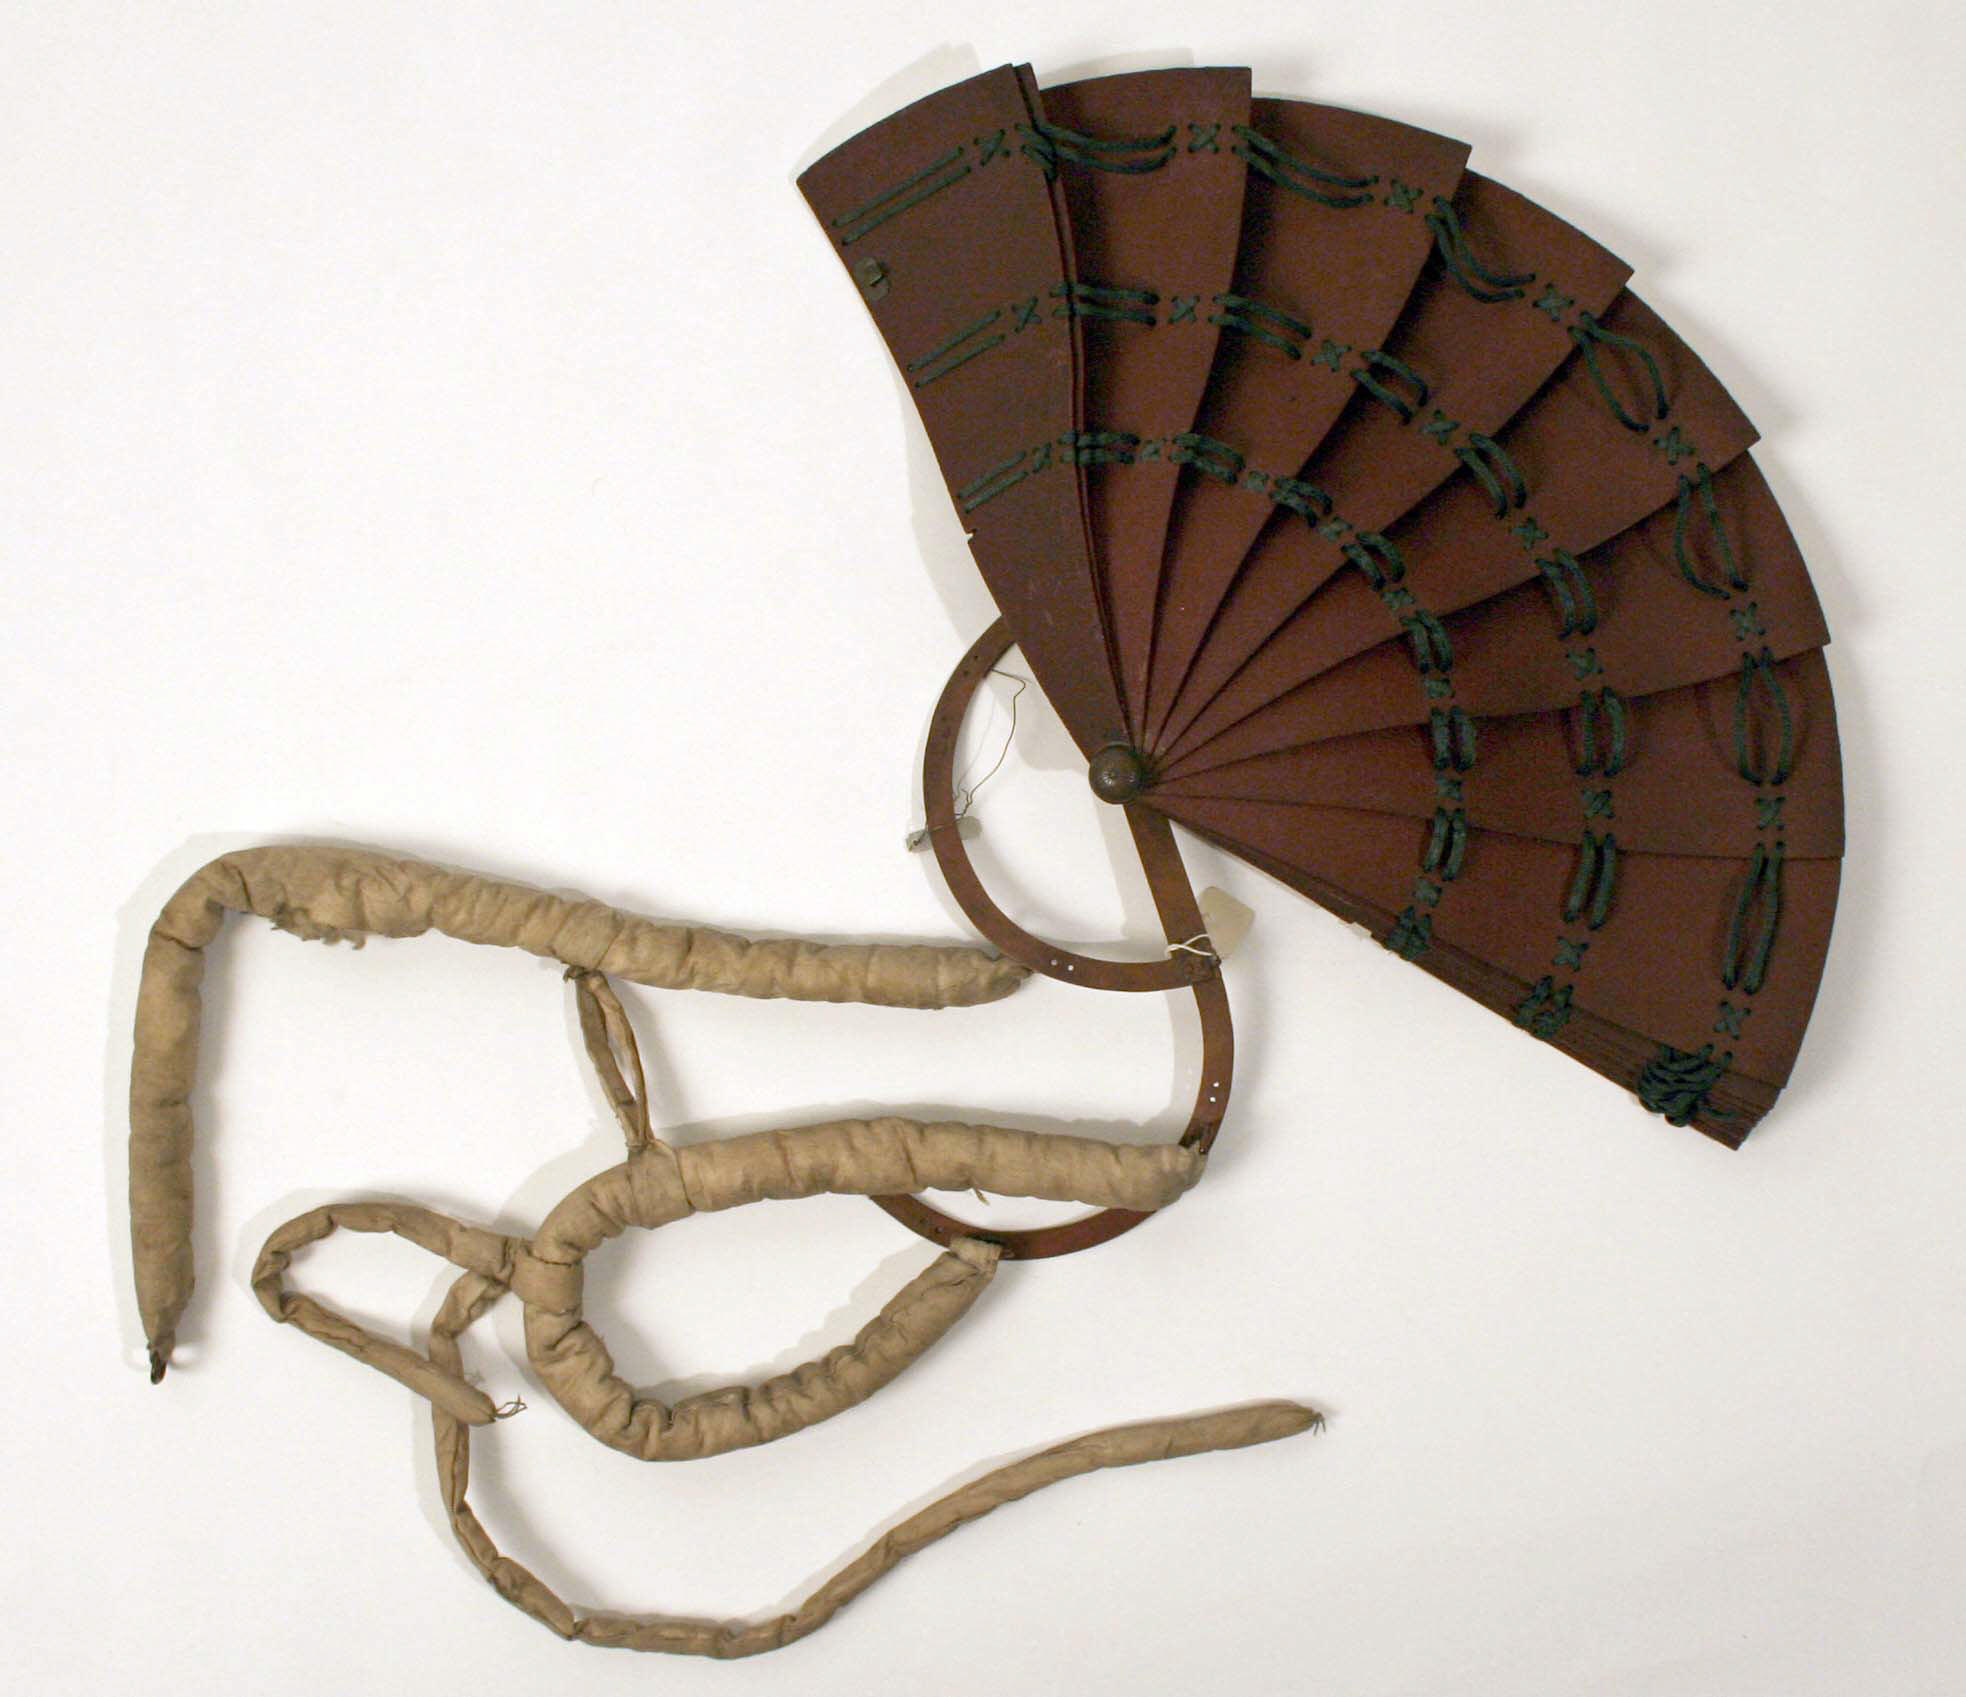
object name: war hat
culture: japanese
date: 1800-1936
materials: gold, lacquer, leather, textile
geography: japan